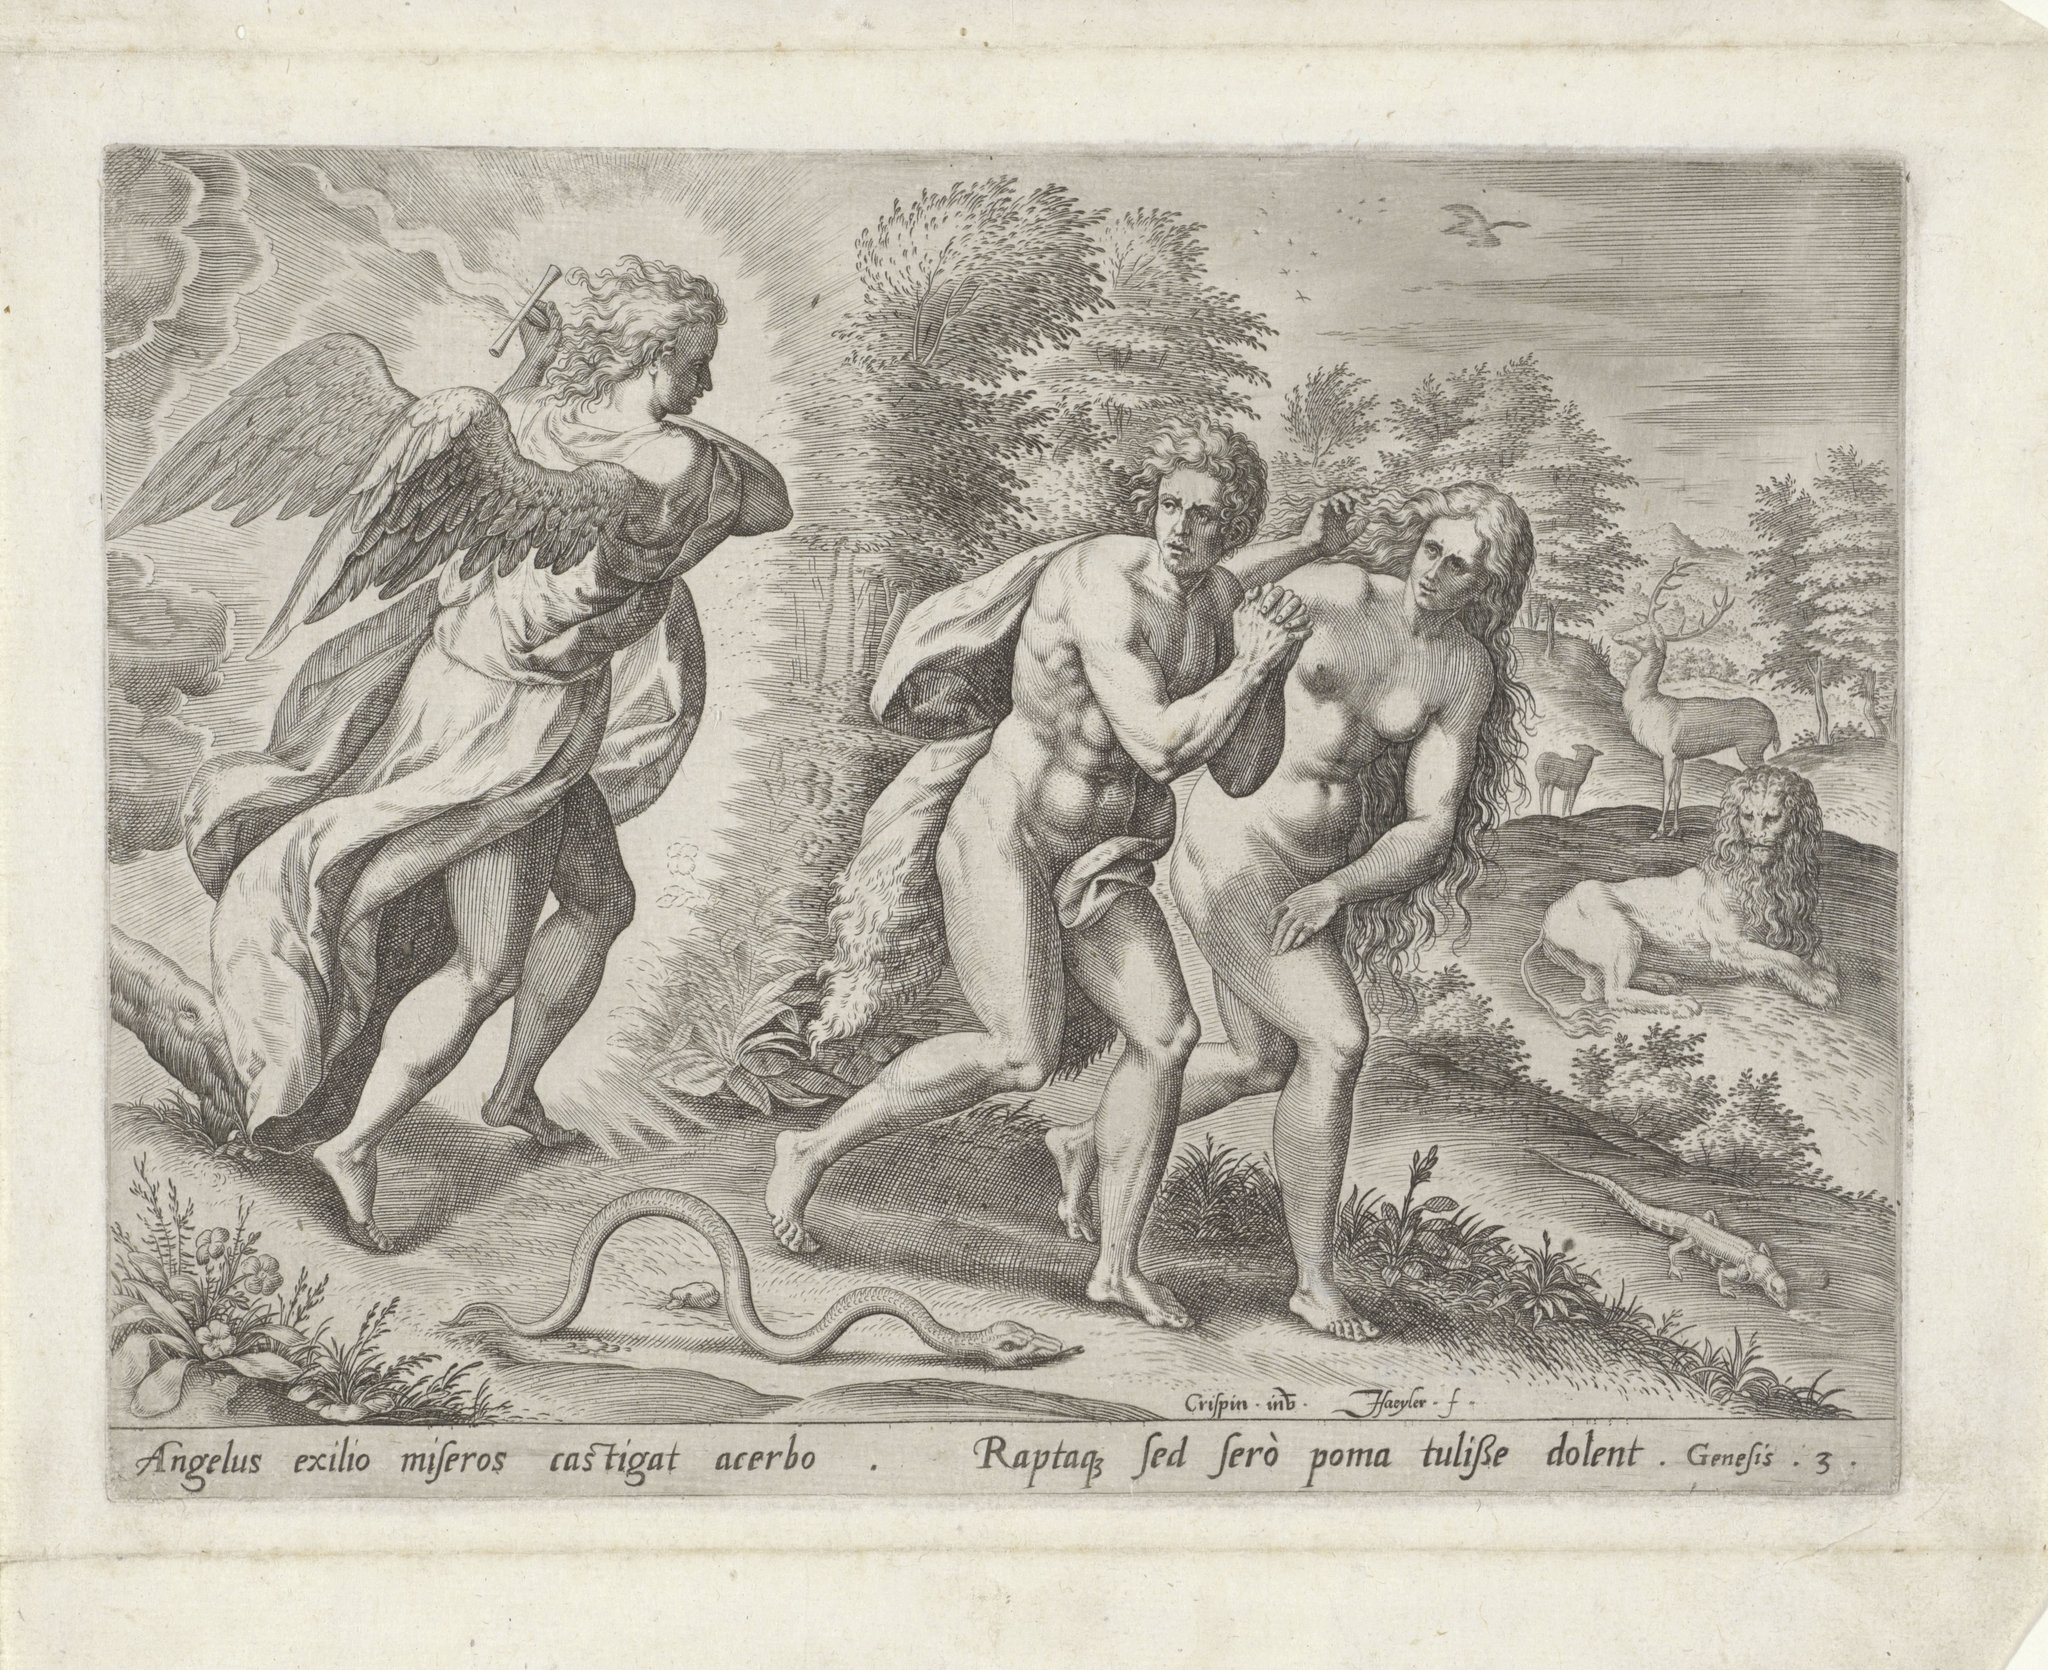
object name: print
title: Expulsion from Paradise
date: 1575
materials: paper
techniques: engraving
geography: antwerp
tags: the snake is cursed by god, and condemned to eat dust and to crawl on its belly, animals, an angel chases adam and eve out of paradise with a (flaming) sword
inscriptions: collector's mark: Lugt 2228, collector's mark: Lugt 2760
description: Adam en Eva bedekken hun naaktheid terwijl zij door de engel met het vlammend zwaard uit het Aards Paradijs worden verdreven. Naast hen kruipt de slang. In de achtergrond verschillende dieren. De zevende prent van een achtdelige reeks over het scheppingsverhaal.